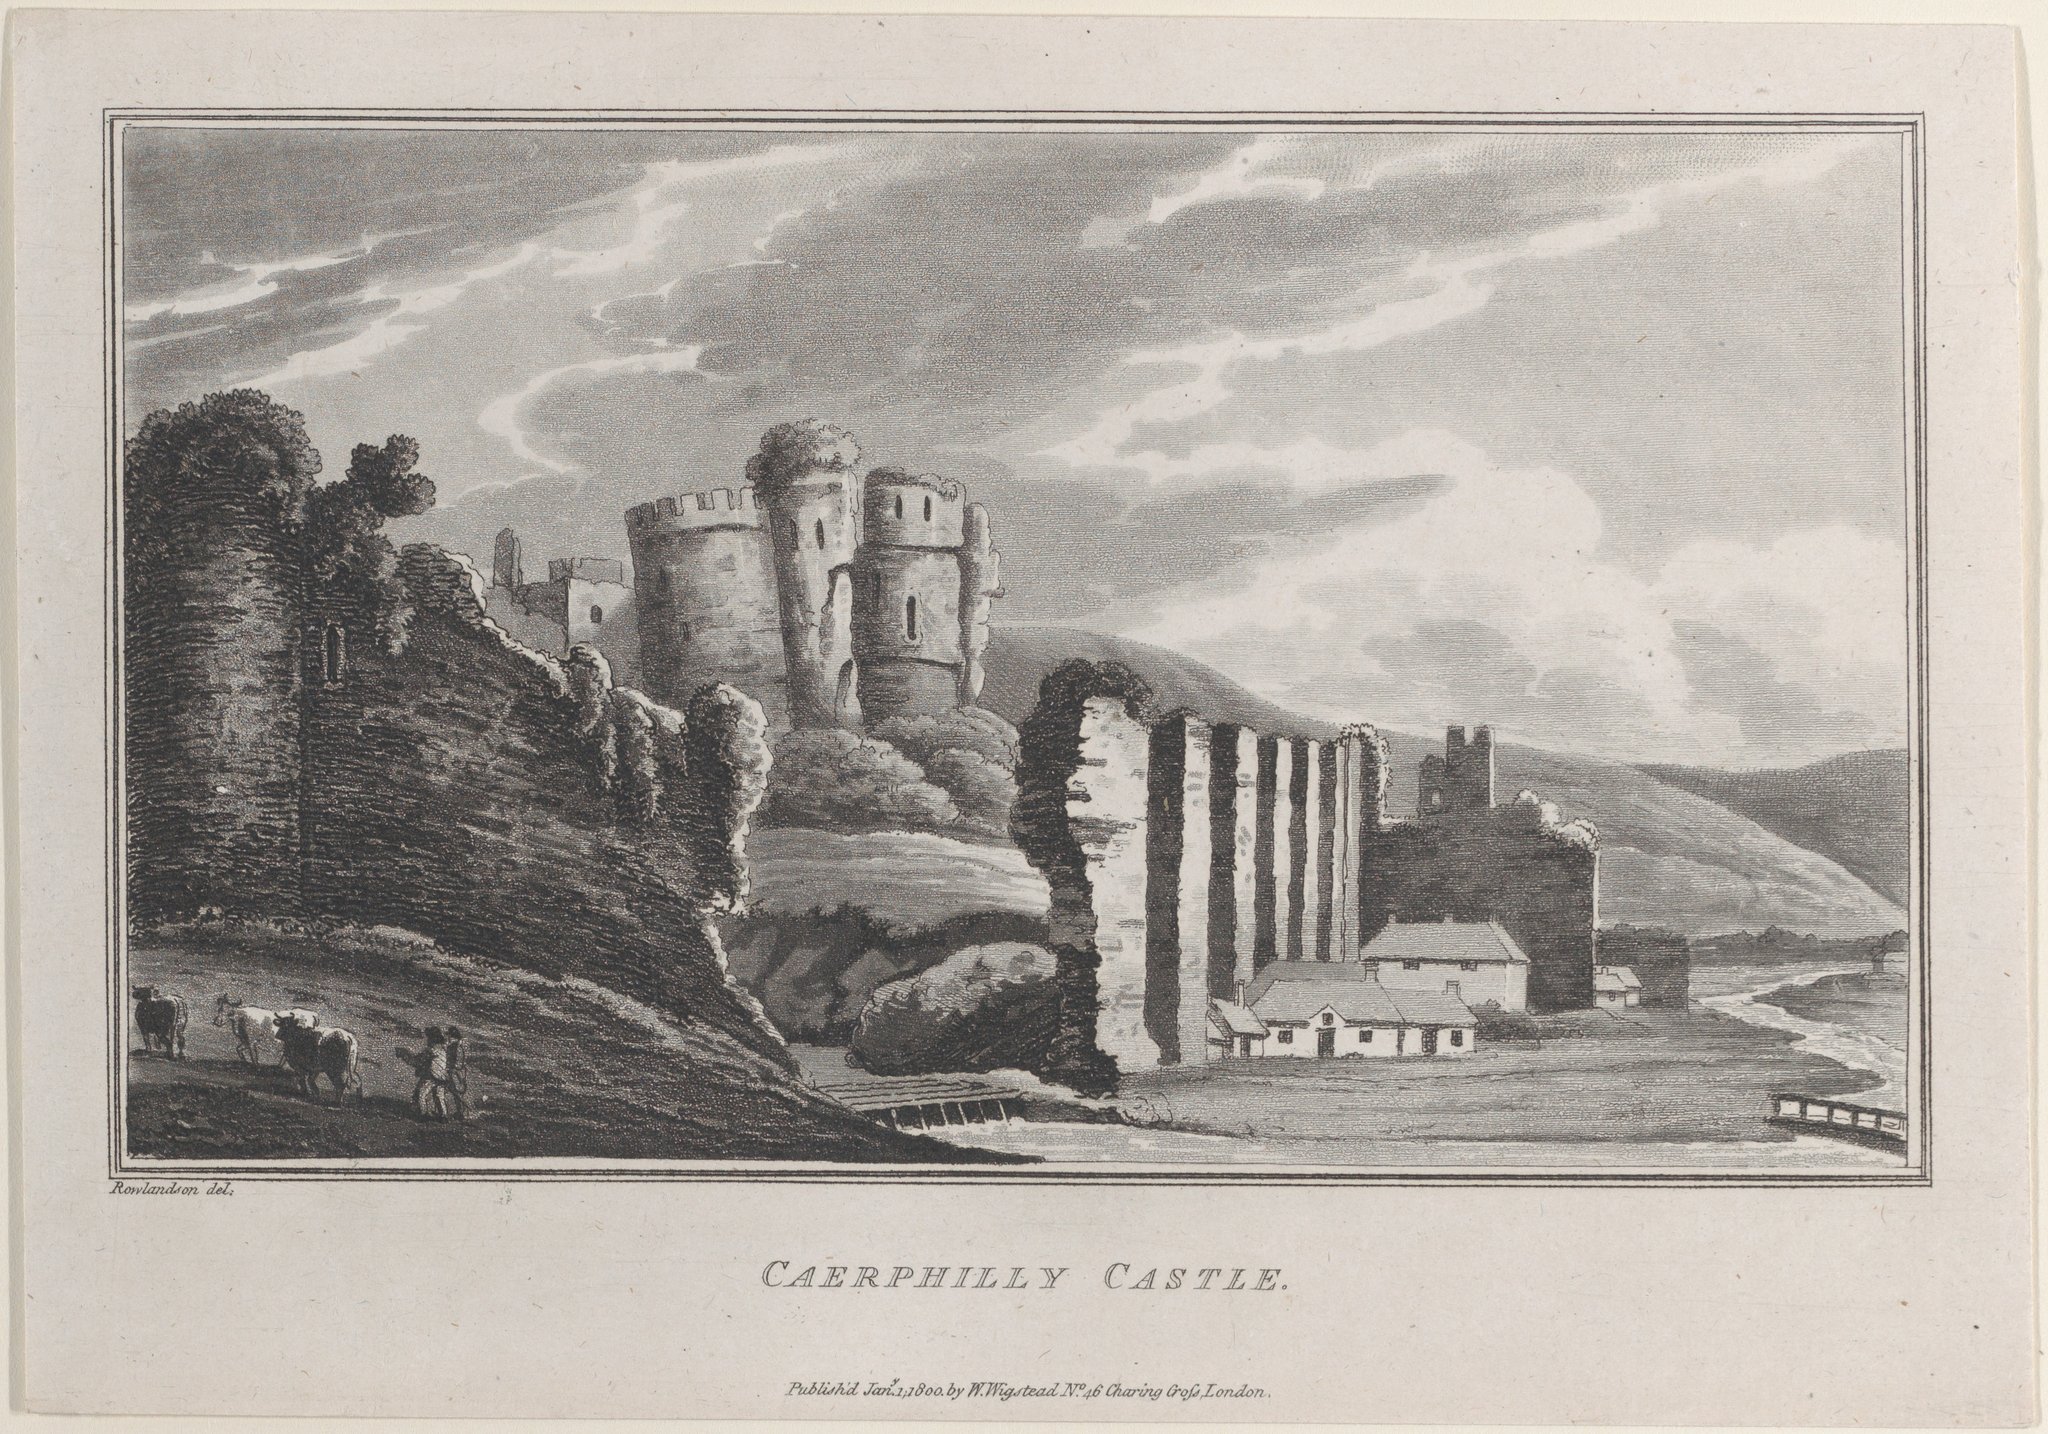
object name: print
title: Caerphilly Castle, from "Remarks on a Tour to North and South Wales, in the year 1797"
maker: john hill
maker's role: artist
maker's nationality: british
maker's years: 1714-1775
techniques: aquatint, etching